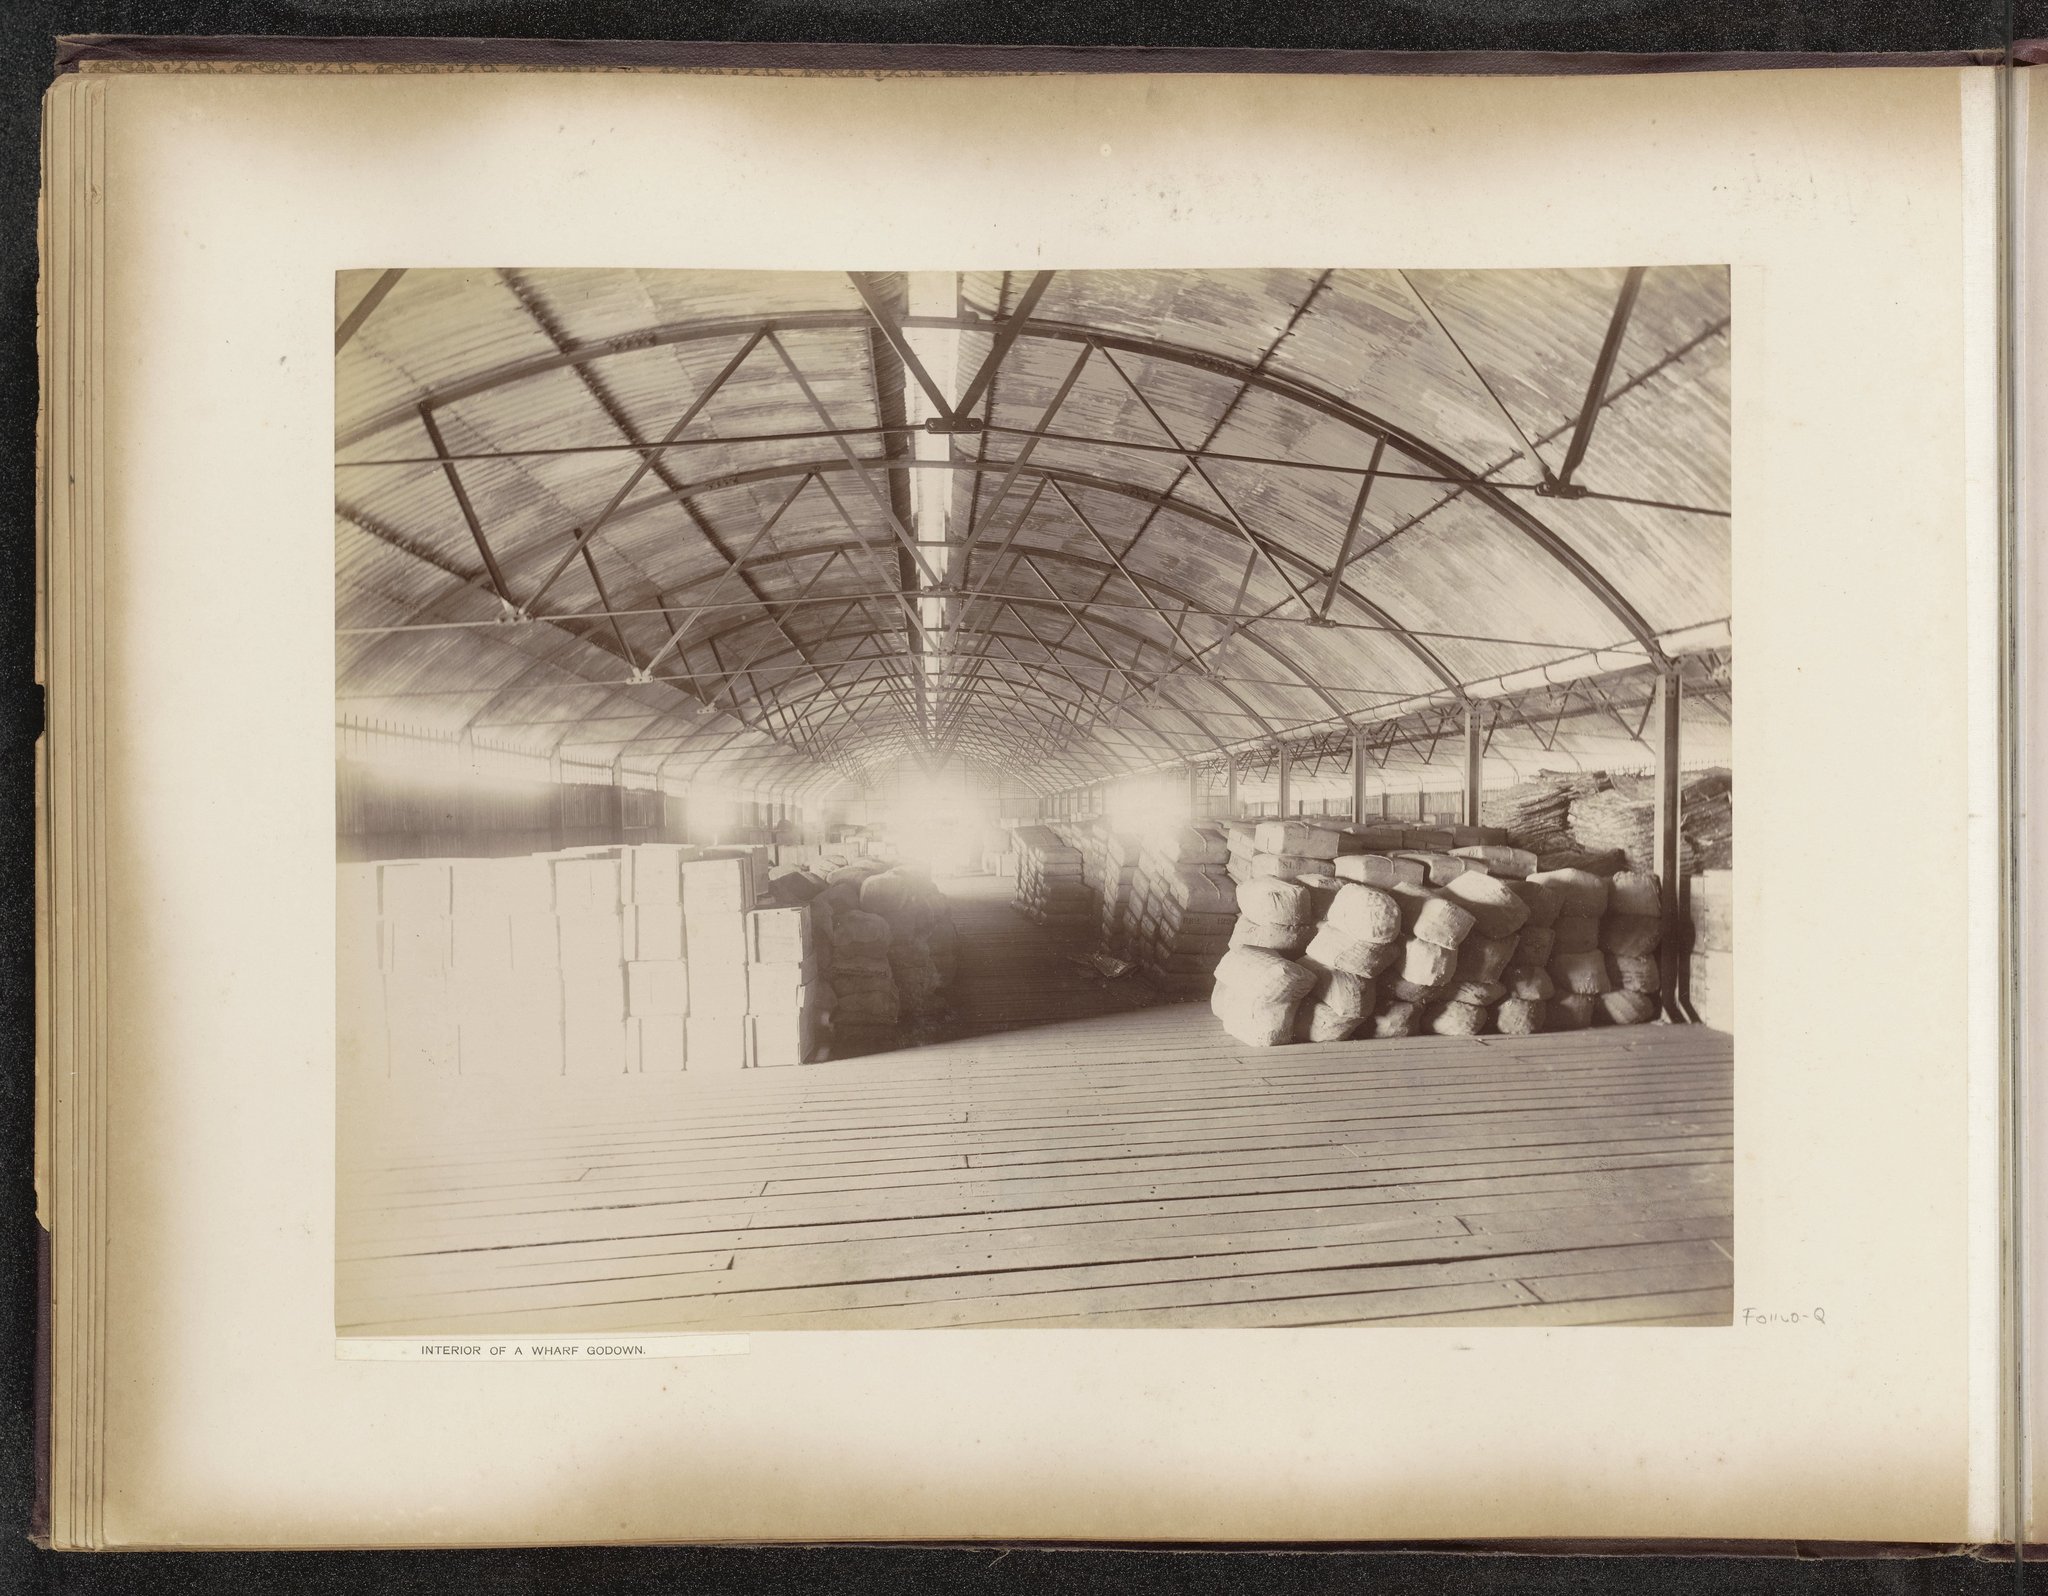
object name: photograph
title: Interior of a wharf godown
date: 1890-1905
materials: photographic support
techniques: albumen print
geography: singapore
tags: warehouse (~ harbour), container made of plant material other than wood: basket, pier, quay, wharf, shipyard, shipdock, shipbuilding industry, singapore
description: Onderdeel van Fotoalbum van de Tanjong Pagar Dock Co. Ltd. in Singapore.